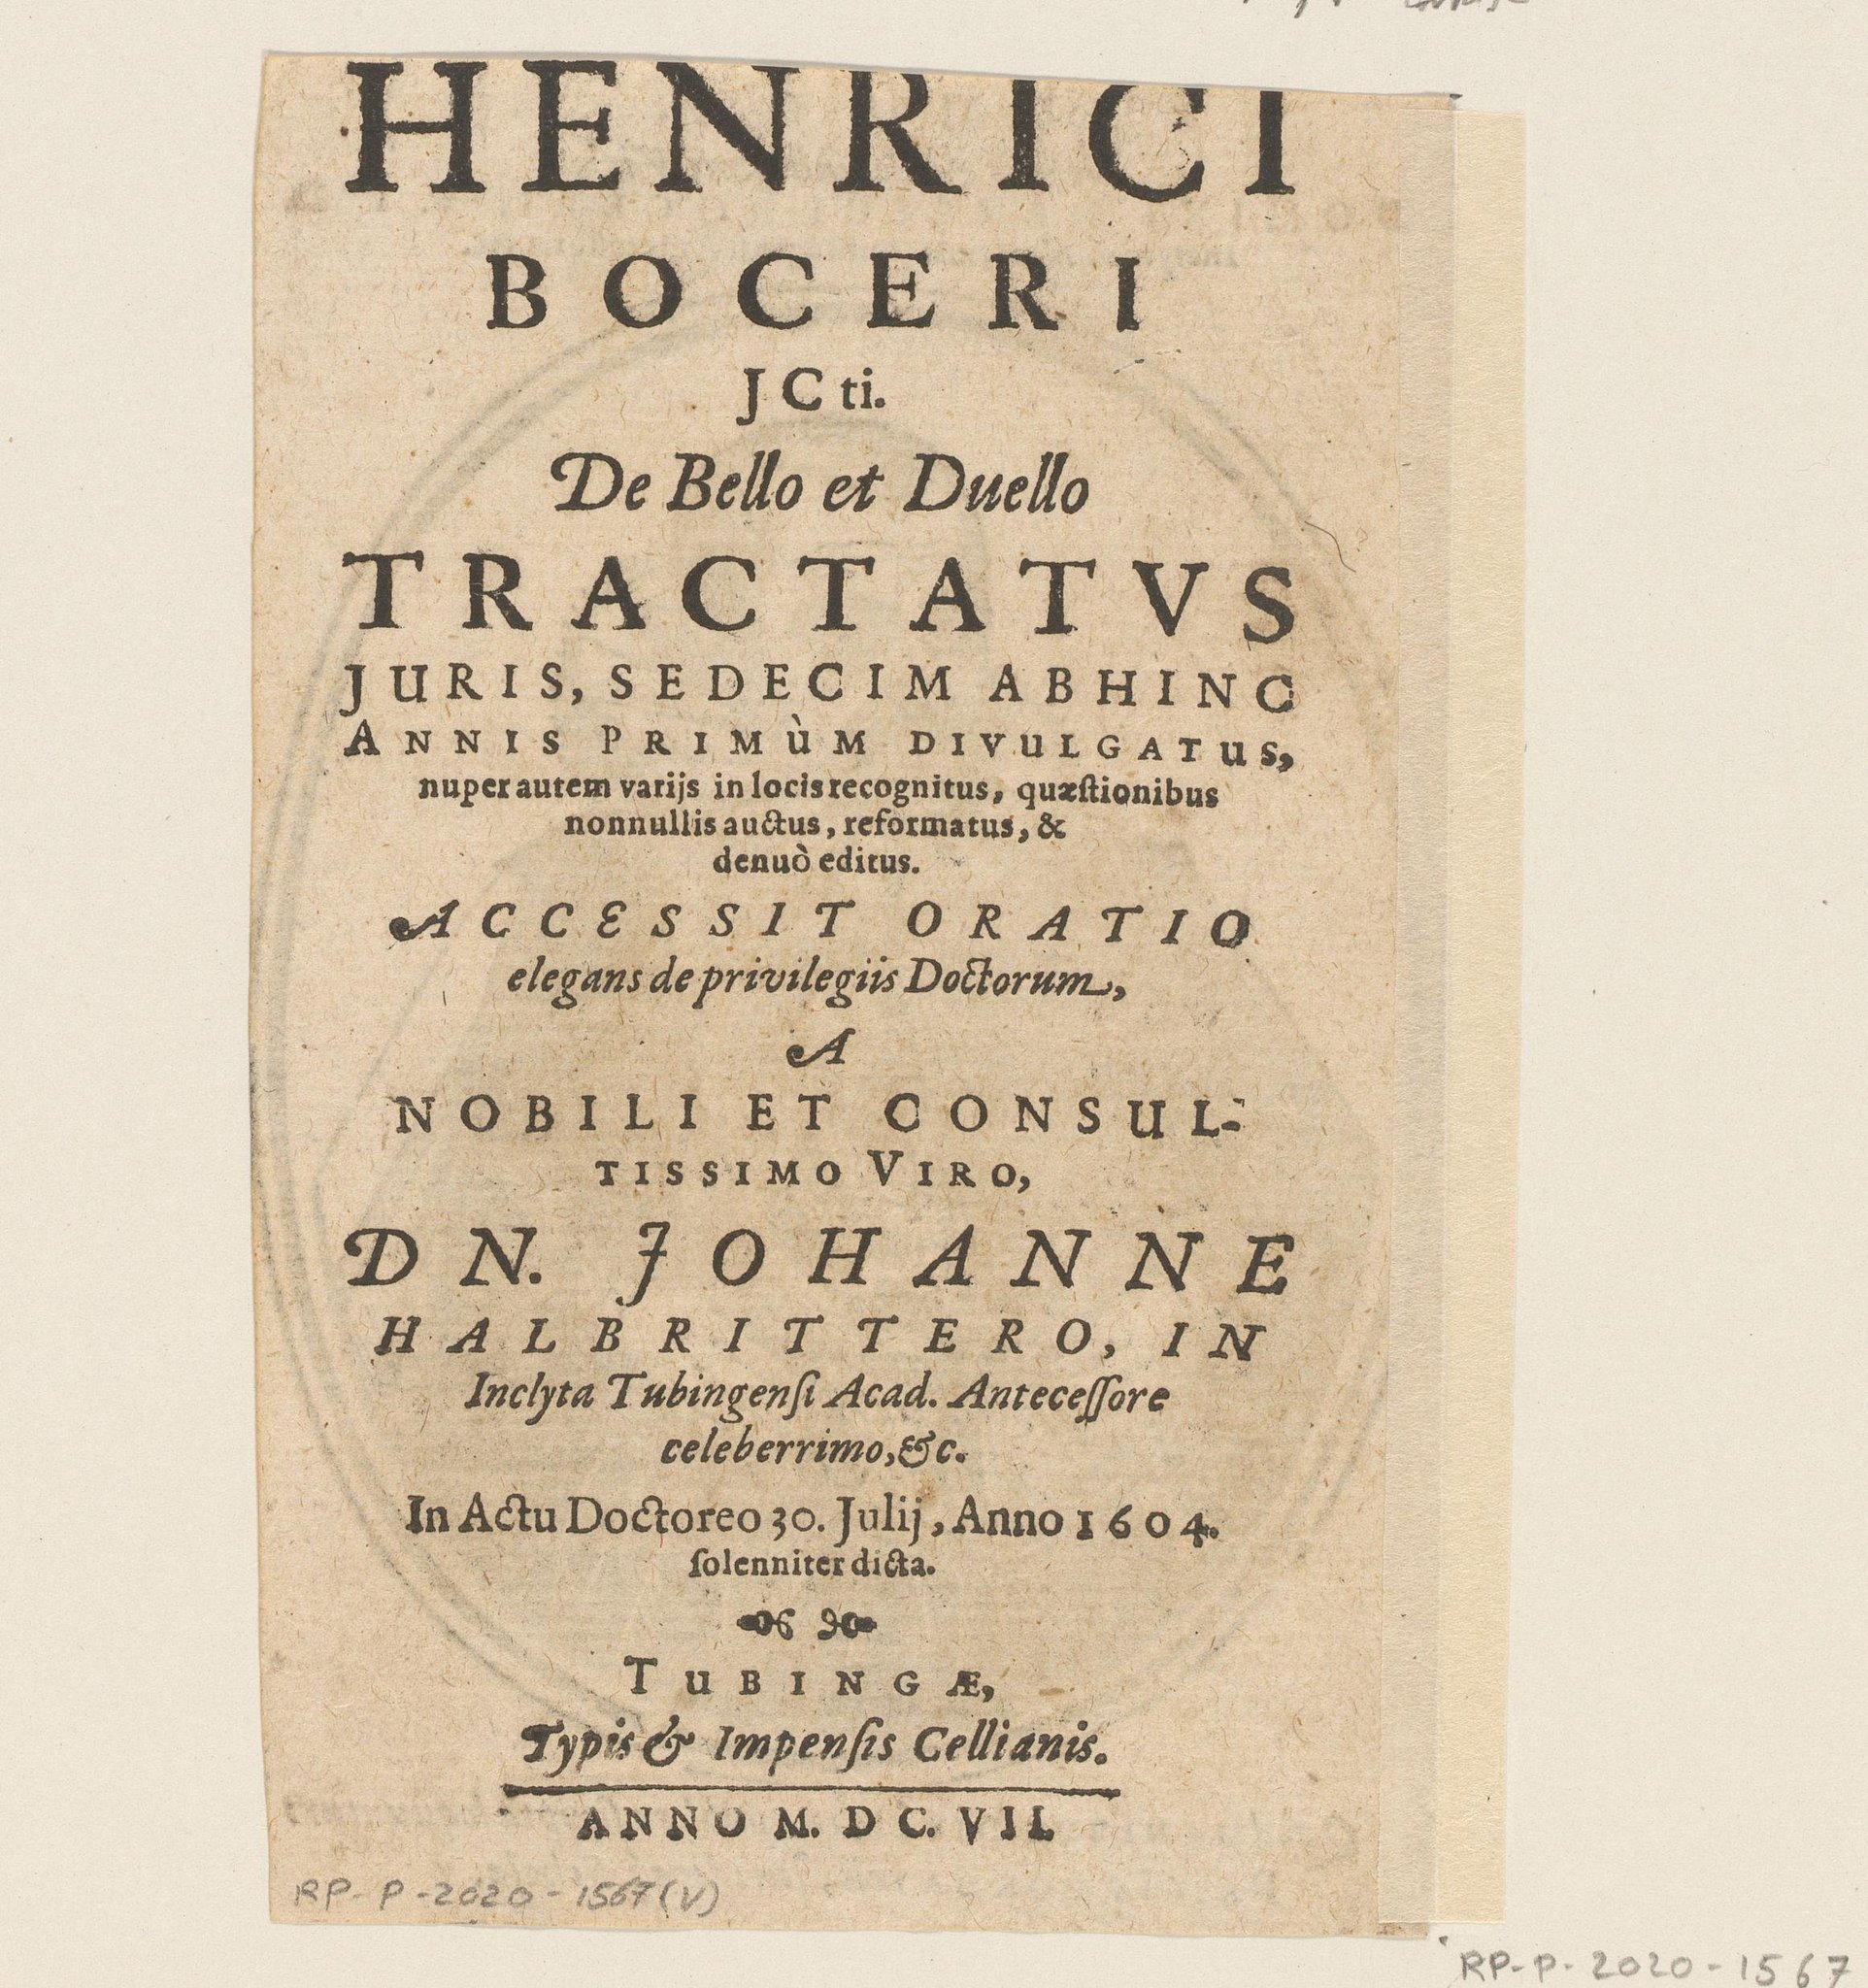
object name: titelblad, titelpagina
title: Titelpagina voor: Heinrich Bocer, De bello et duello tractatus juris, 1607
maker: johann alexander cellius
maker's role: printer, publisher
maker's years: 1578-1624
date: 1607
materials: paper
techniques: letterpress printing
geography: tübingen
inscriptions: date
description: Titelpagina voor: Bocer, Heinrich. De bello et duello tractatus juris (...). Tübingen: Johann Alexander Cellius, 1607.